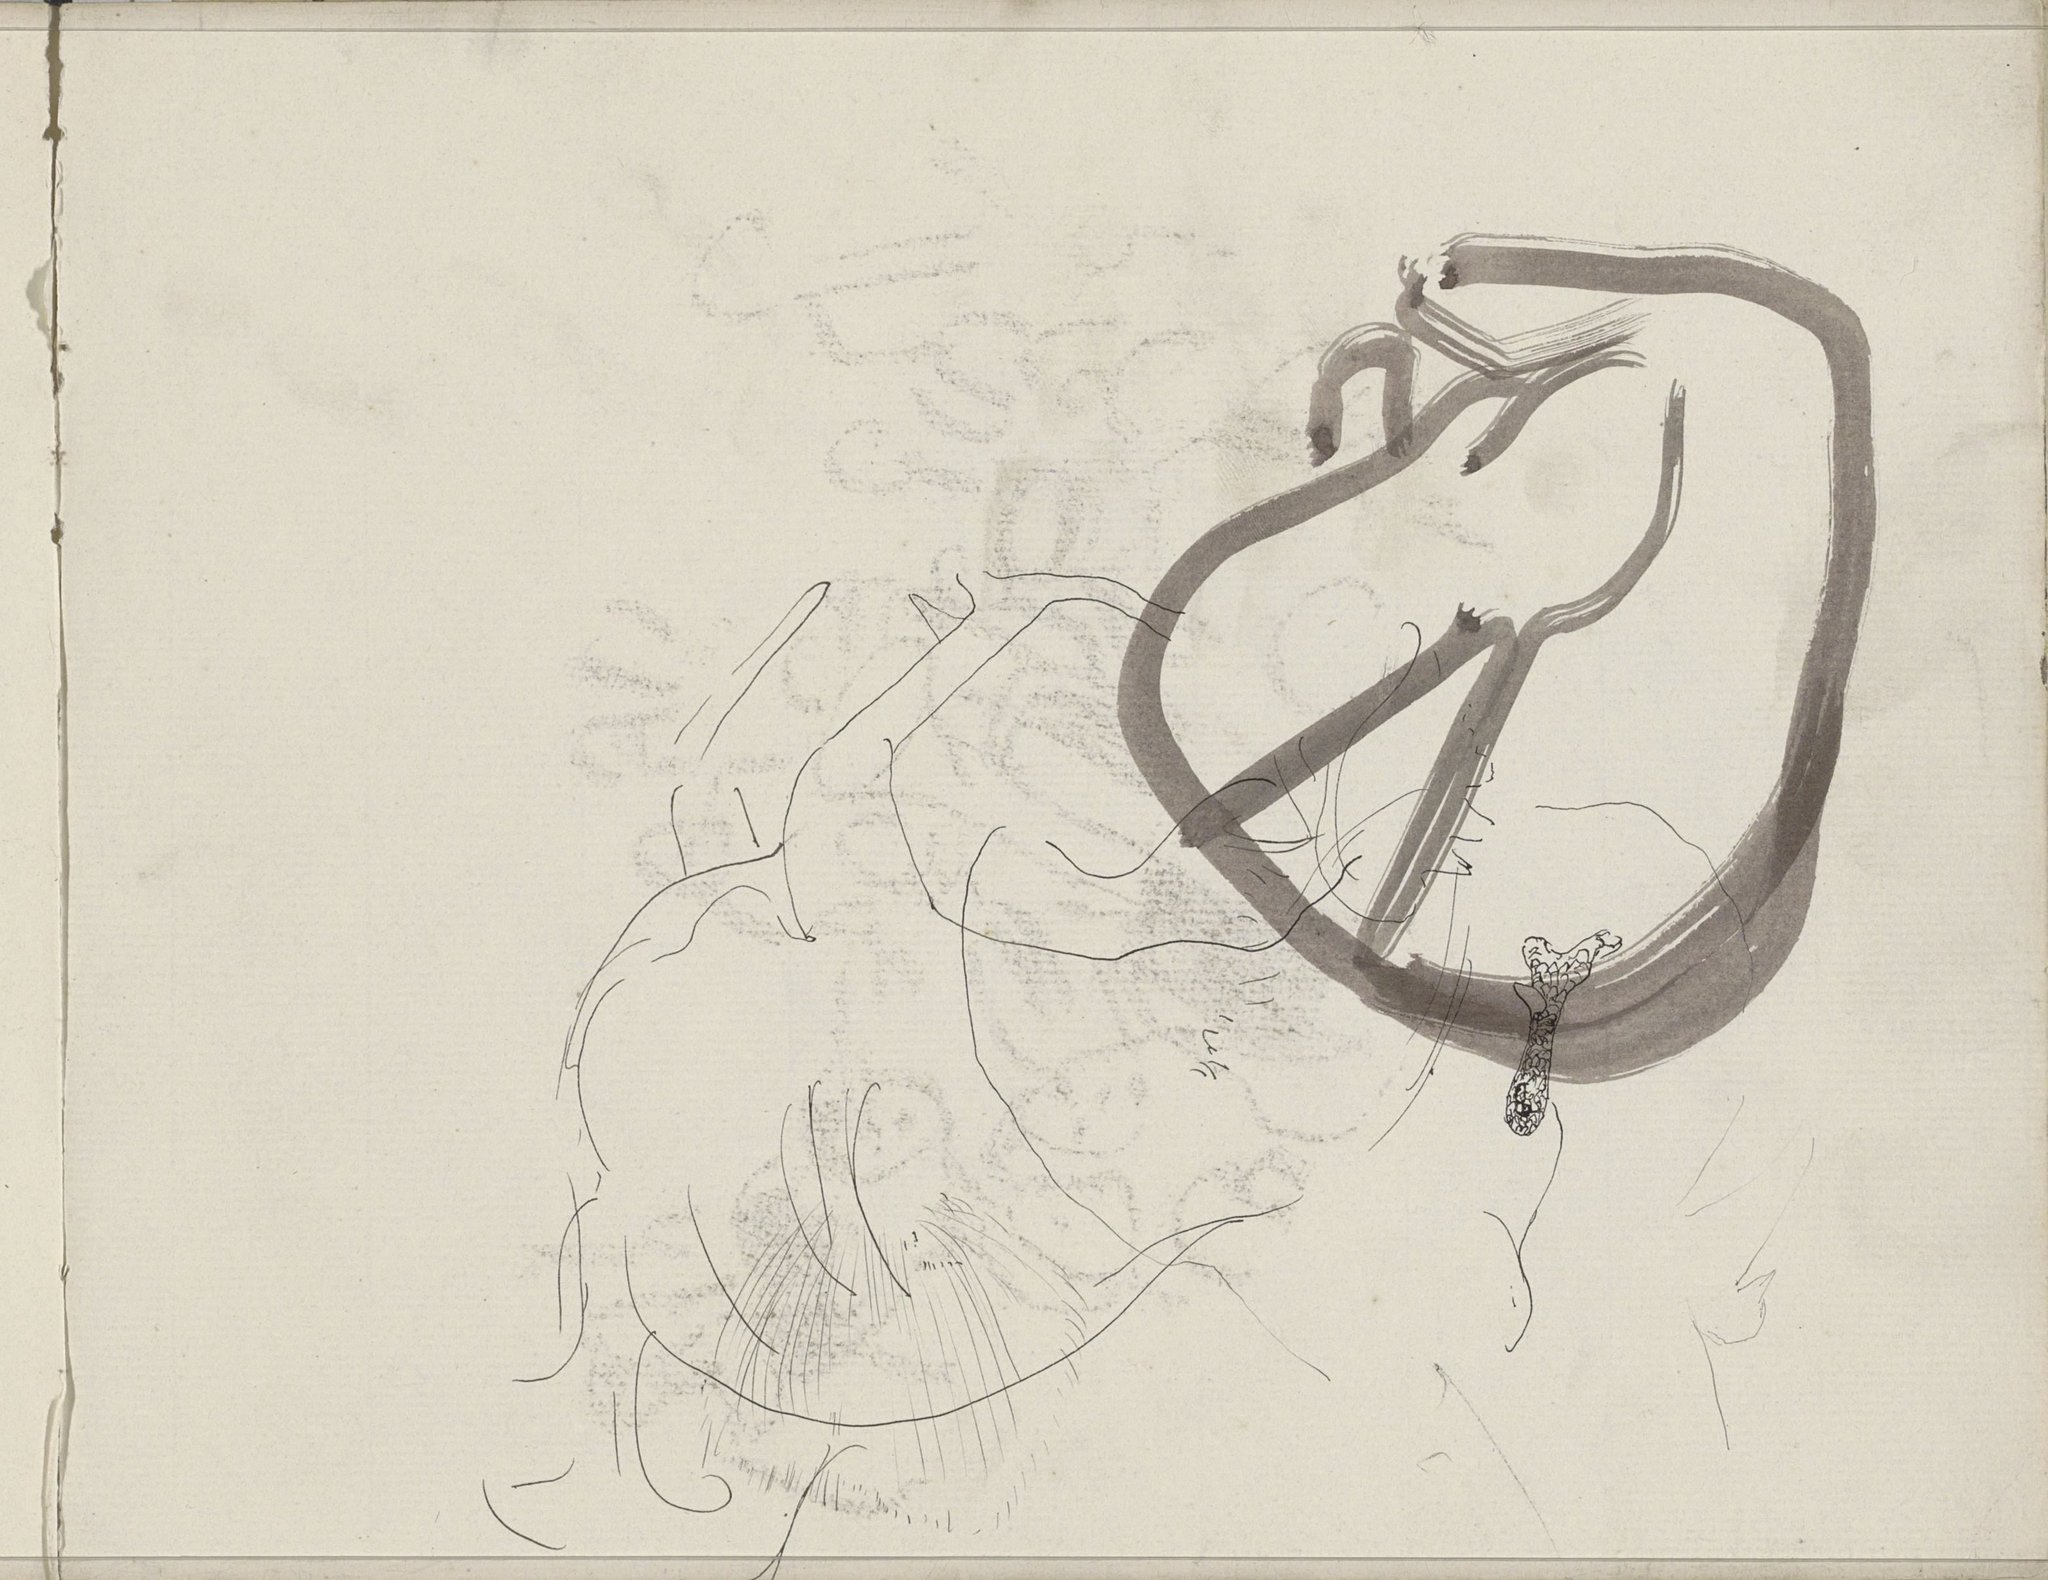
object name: sketchbook leaf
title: Dier en een vogelpoot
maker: carel adolph lion cachet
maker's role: draughtsman, print maker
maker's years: 1864-1945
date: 1896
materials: ink, paper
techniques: brush, pen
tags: wind instruments, fowl (cock, hen, chicken, etc.)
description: Mogelijk een studie van een konijn. Blad 34 recto uit een schetsboek met 44 bladen.